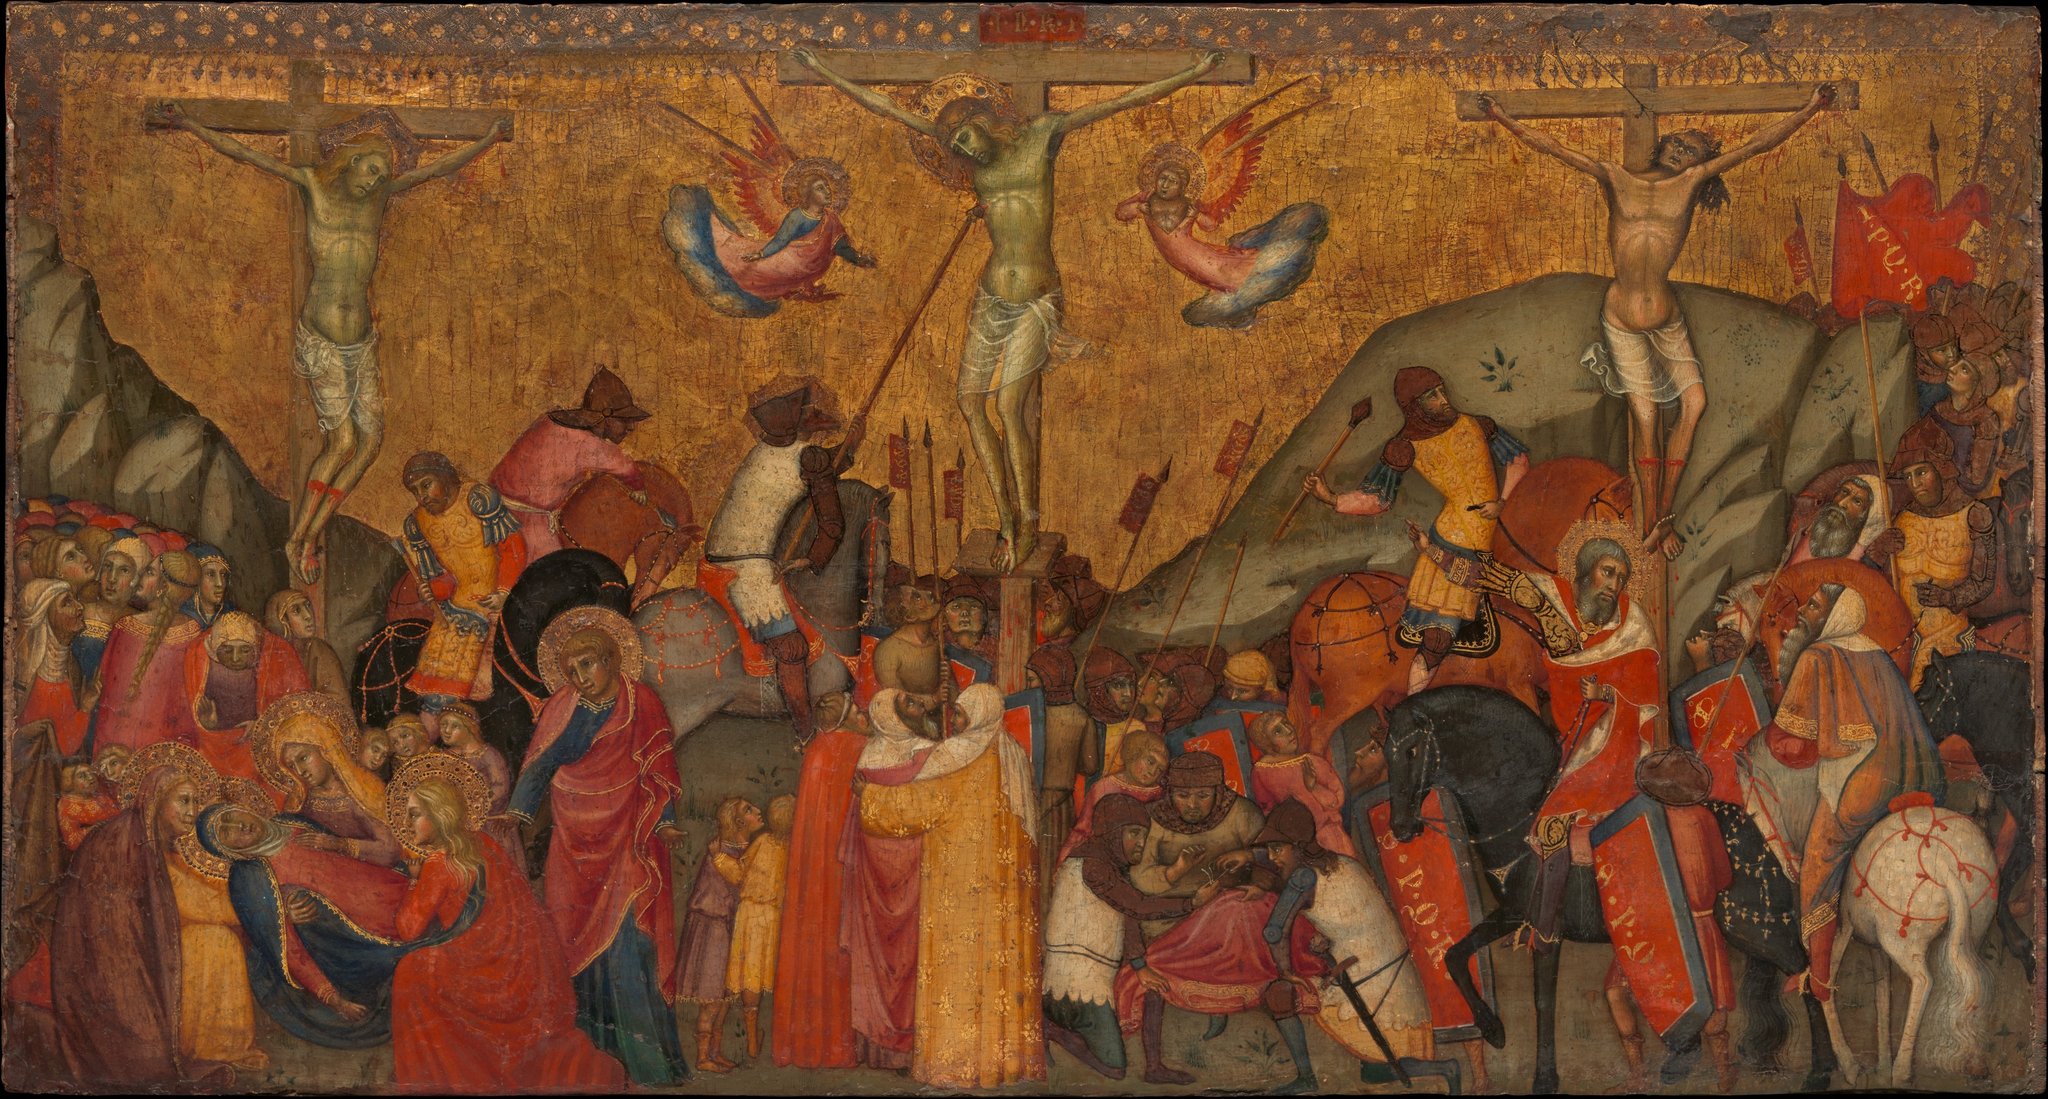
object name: painting, predella panel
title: The Crucifixion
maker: andrea di bartolo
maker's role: artist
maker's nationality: italian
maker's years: 1389-1428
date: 1389-1428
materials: gold leaf, paint, wood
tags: soldiers,men,horses,mountains,angels,christ,virgin mary,crucifixion